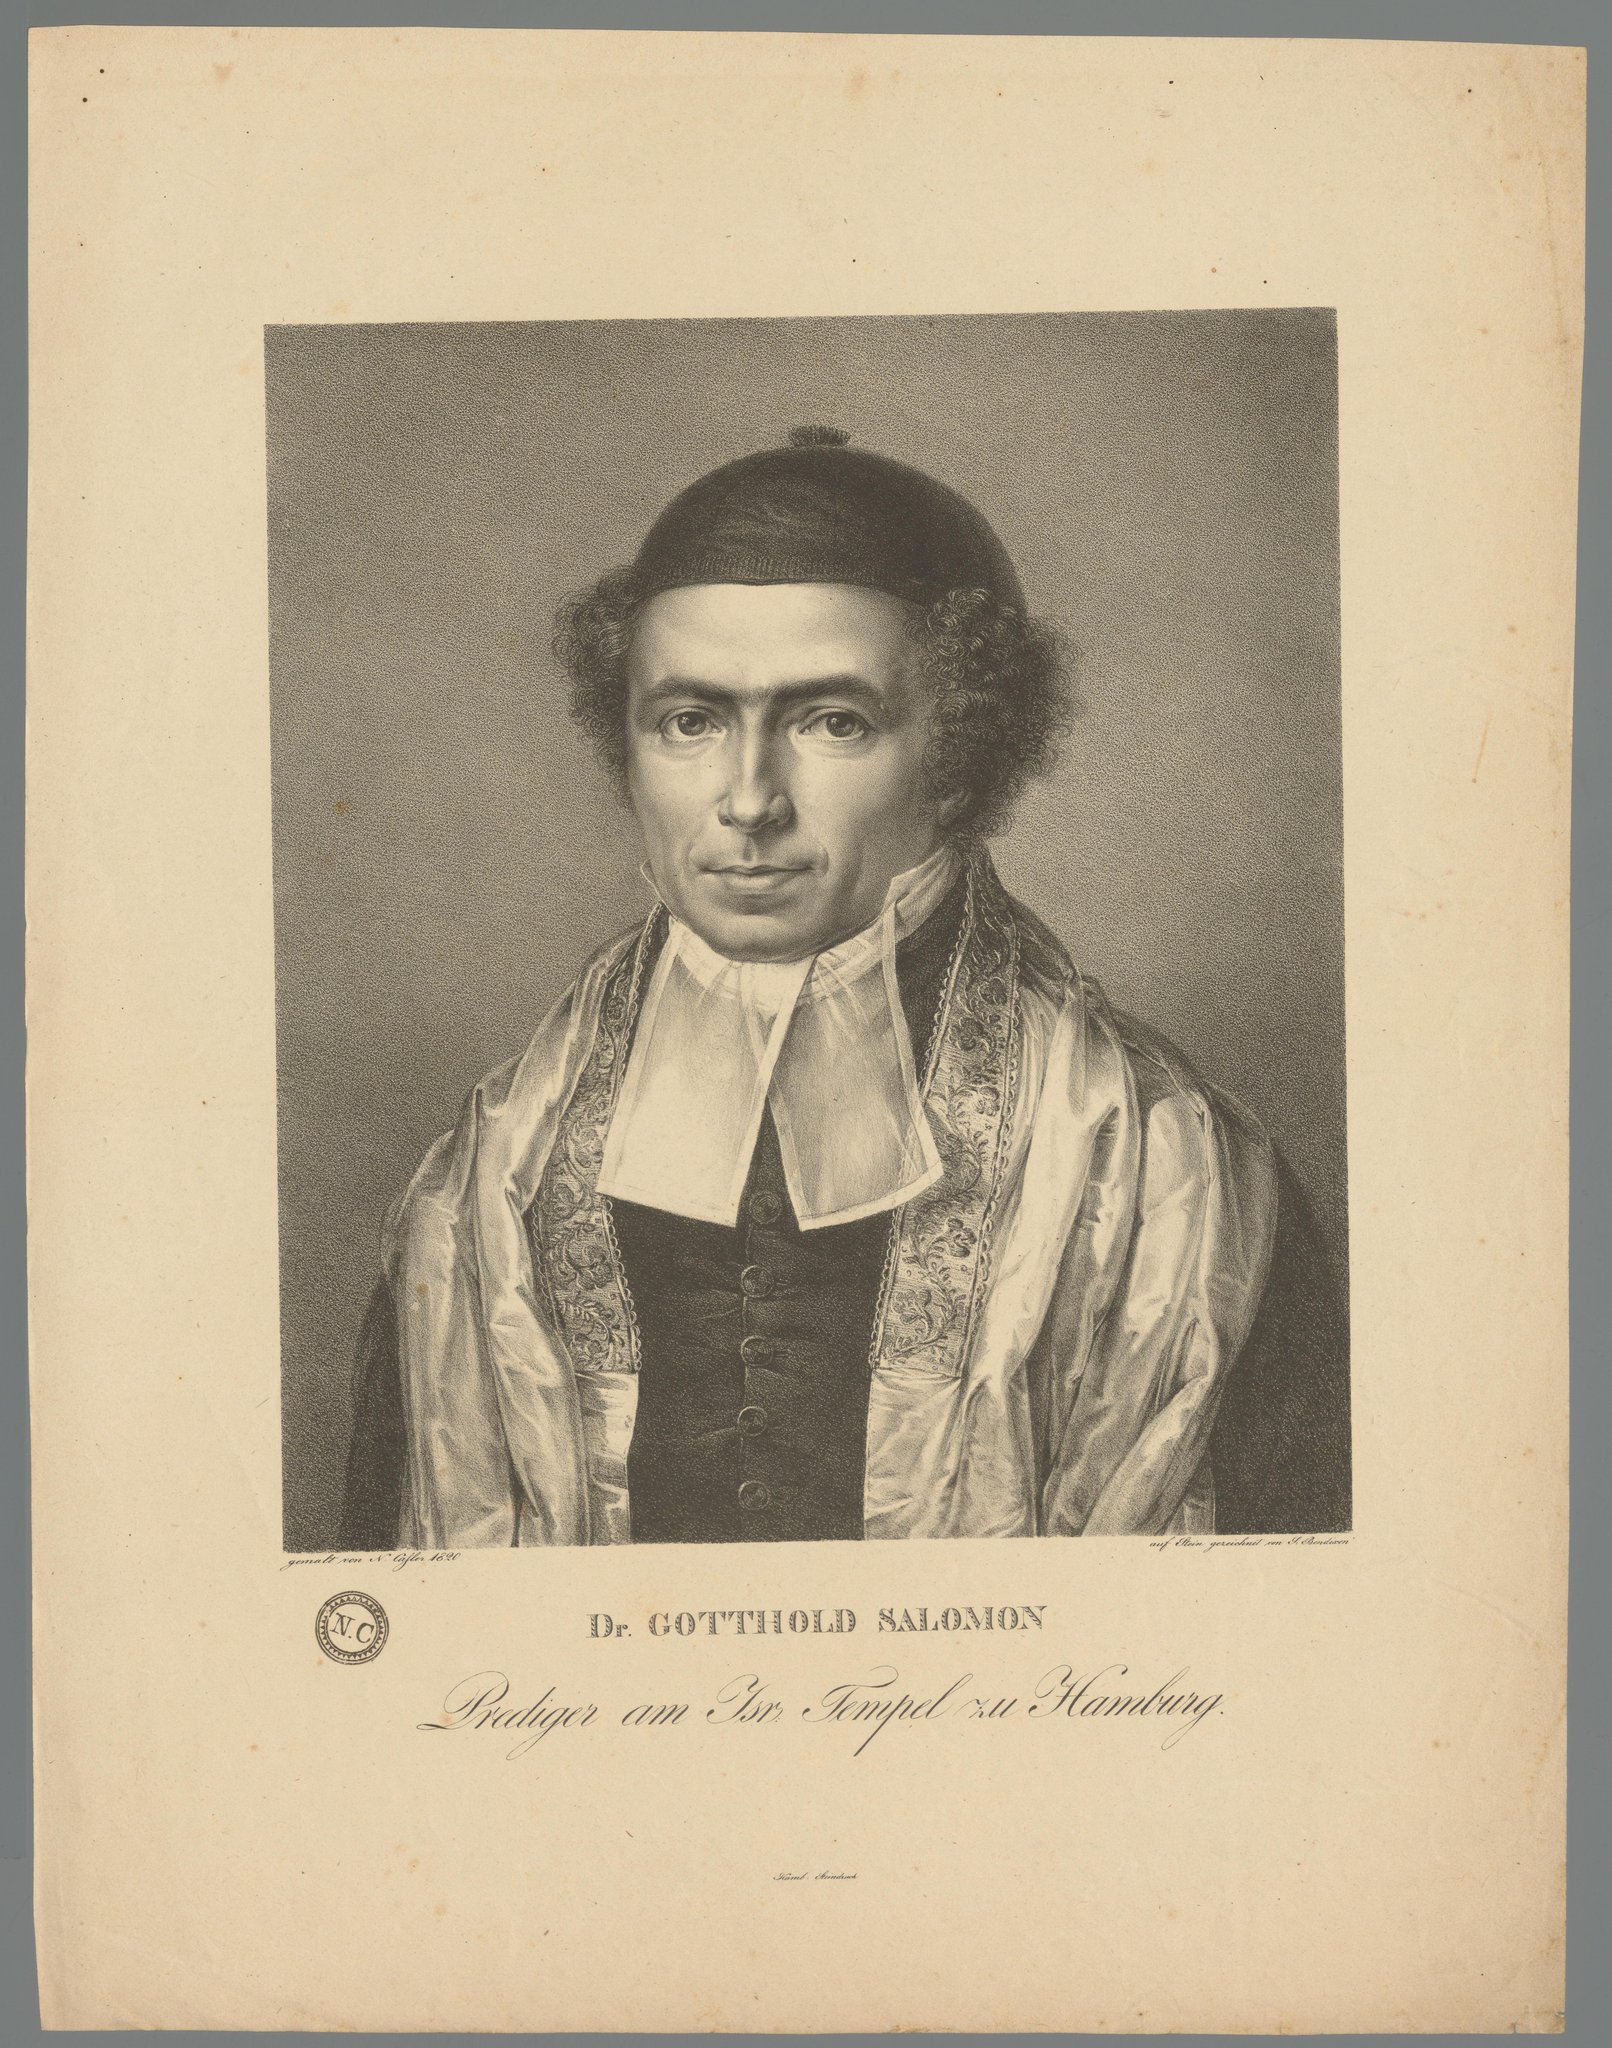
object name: print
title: Dr. Gotthold Salomon Prediger am Isr. Tempel zu Hamburg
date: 1820-1864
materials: paper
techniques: lithograph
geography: hamburg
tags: adult man, historical persons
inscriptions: collector's mark: Lugt 2228, mark: ‘N.C’